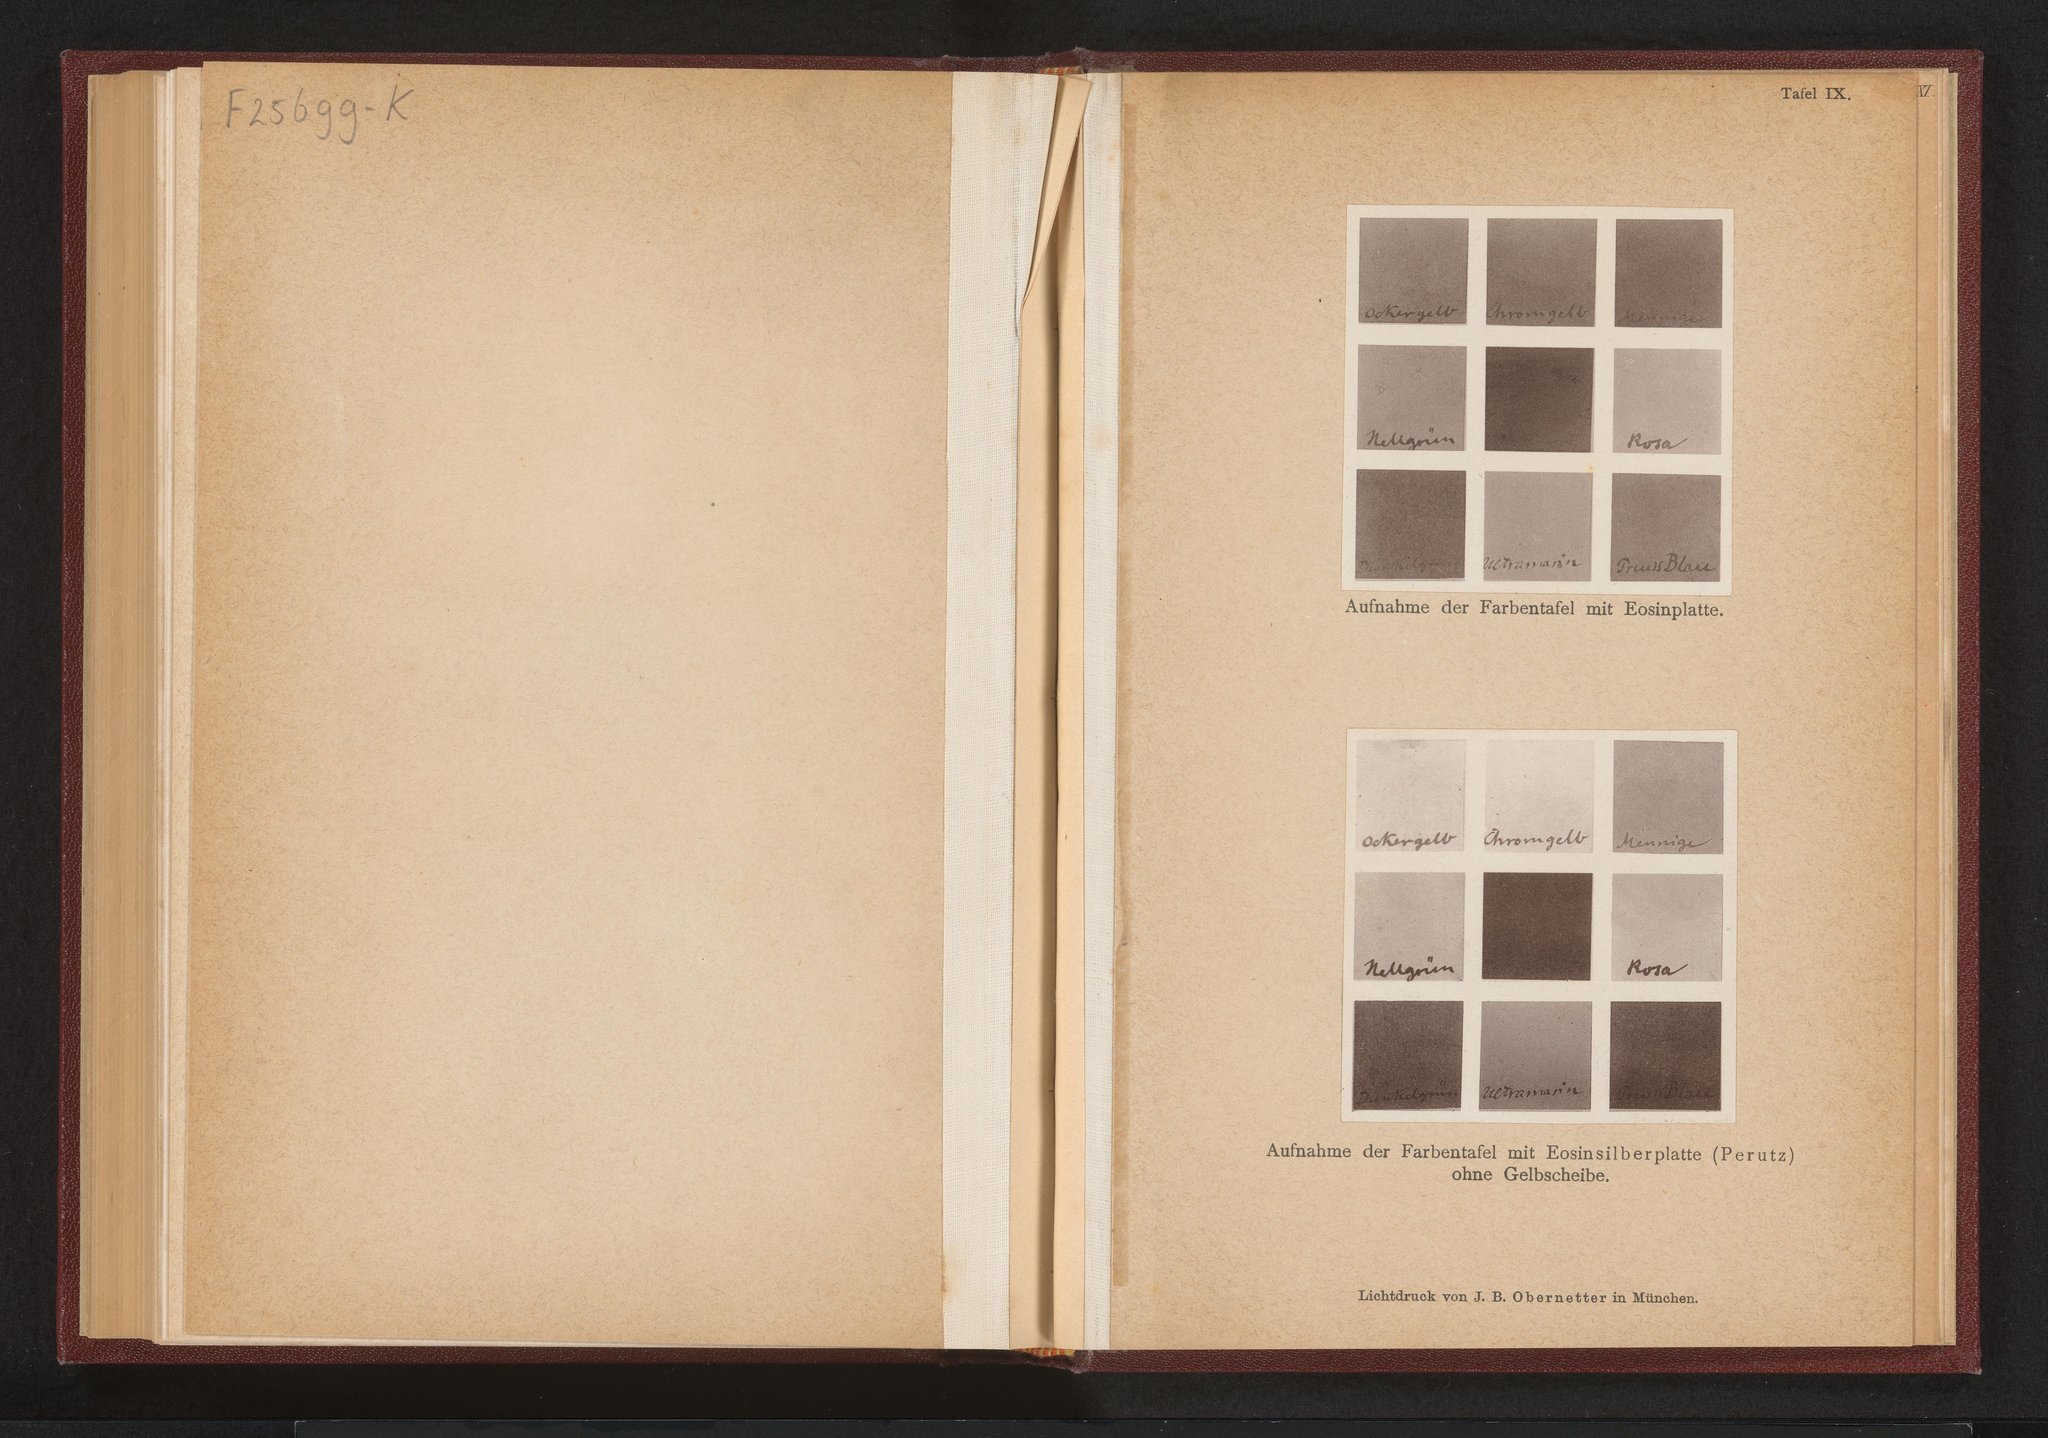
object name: reproduction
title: Twee reproducties van teststalen met negen kleuren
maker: johann baptist obernetter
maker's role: printer, publisher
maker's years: 1840-1887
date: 1885-1890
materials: paper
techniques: photograph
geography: munich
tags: colours, pigments, and paints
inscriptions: inscription: ‘Aufnahme der Farbentafel mit Eosinsilberplatte (Perutz)/ ohne Gelbscheibe.’, inscription: ‘Aufnahme der Farbentafel mit Eosinplatte.’, number: ‘Tafel IX.’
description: Prenten op achttiende ongenummerde pagina na pagina 351.